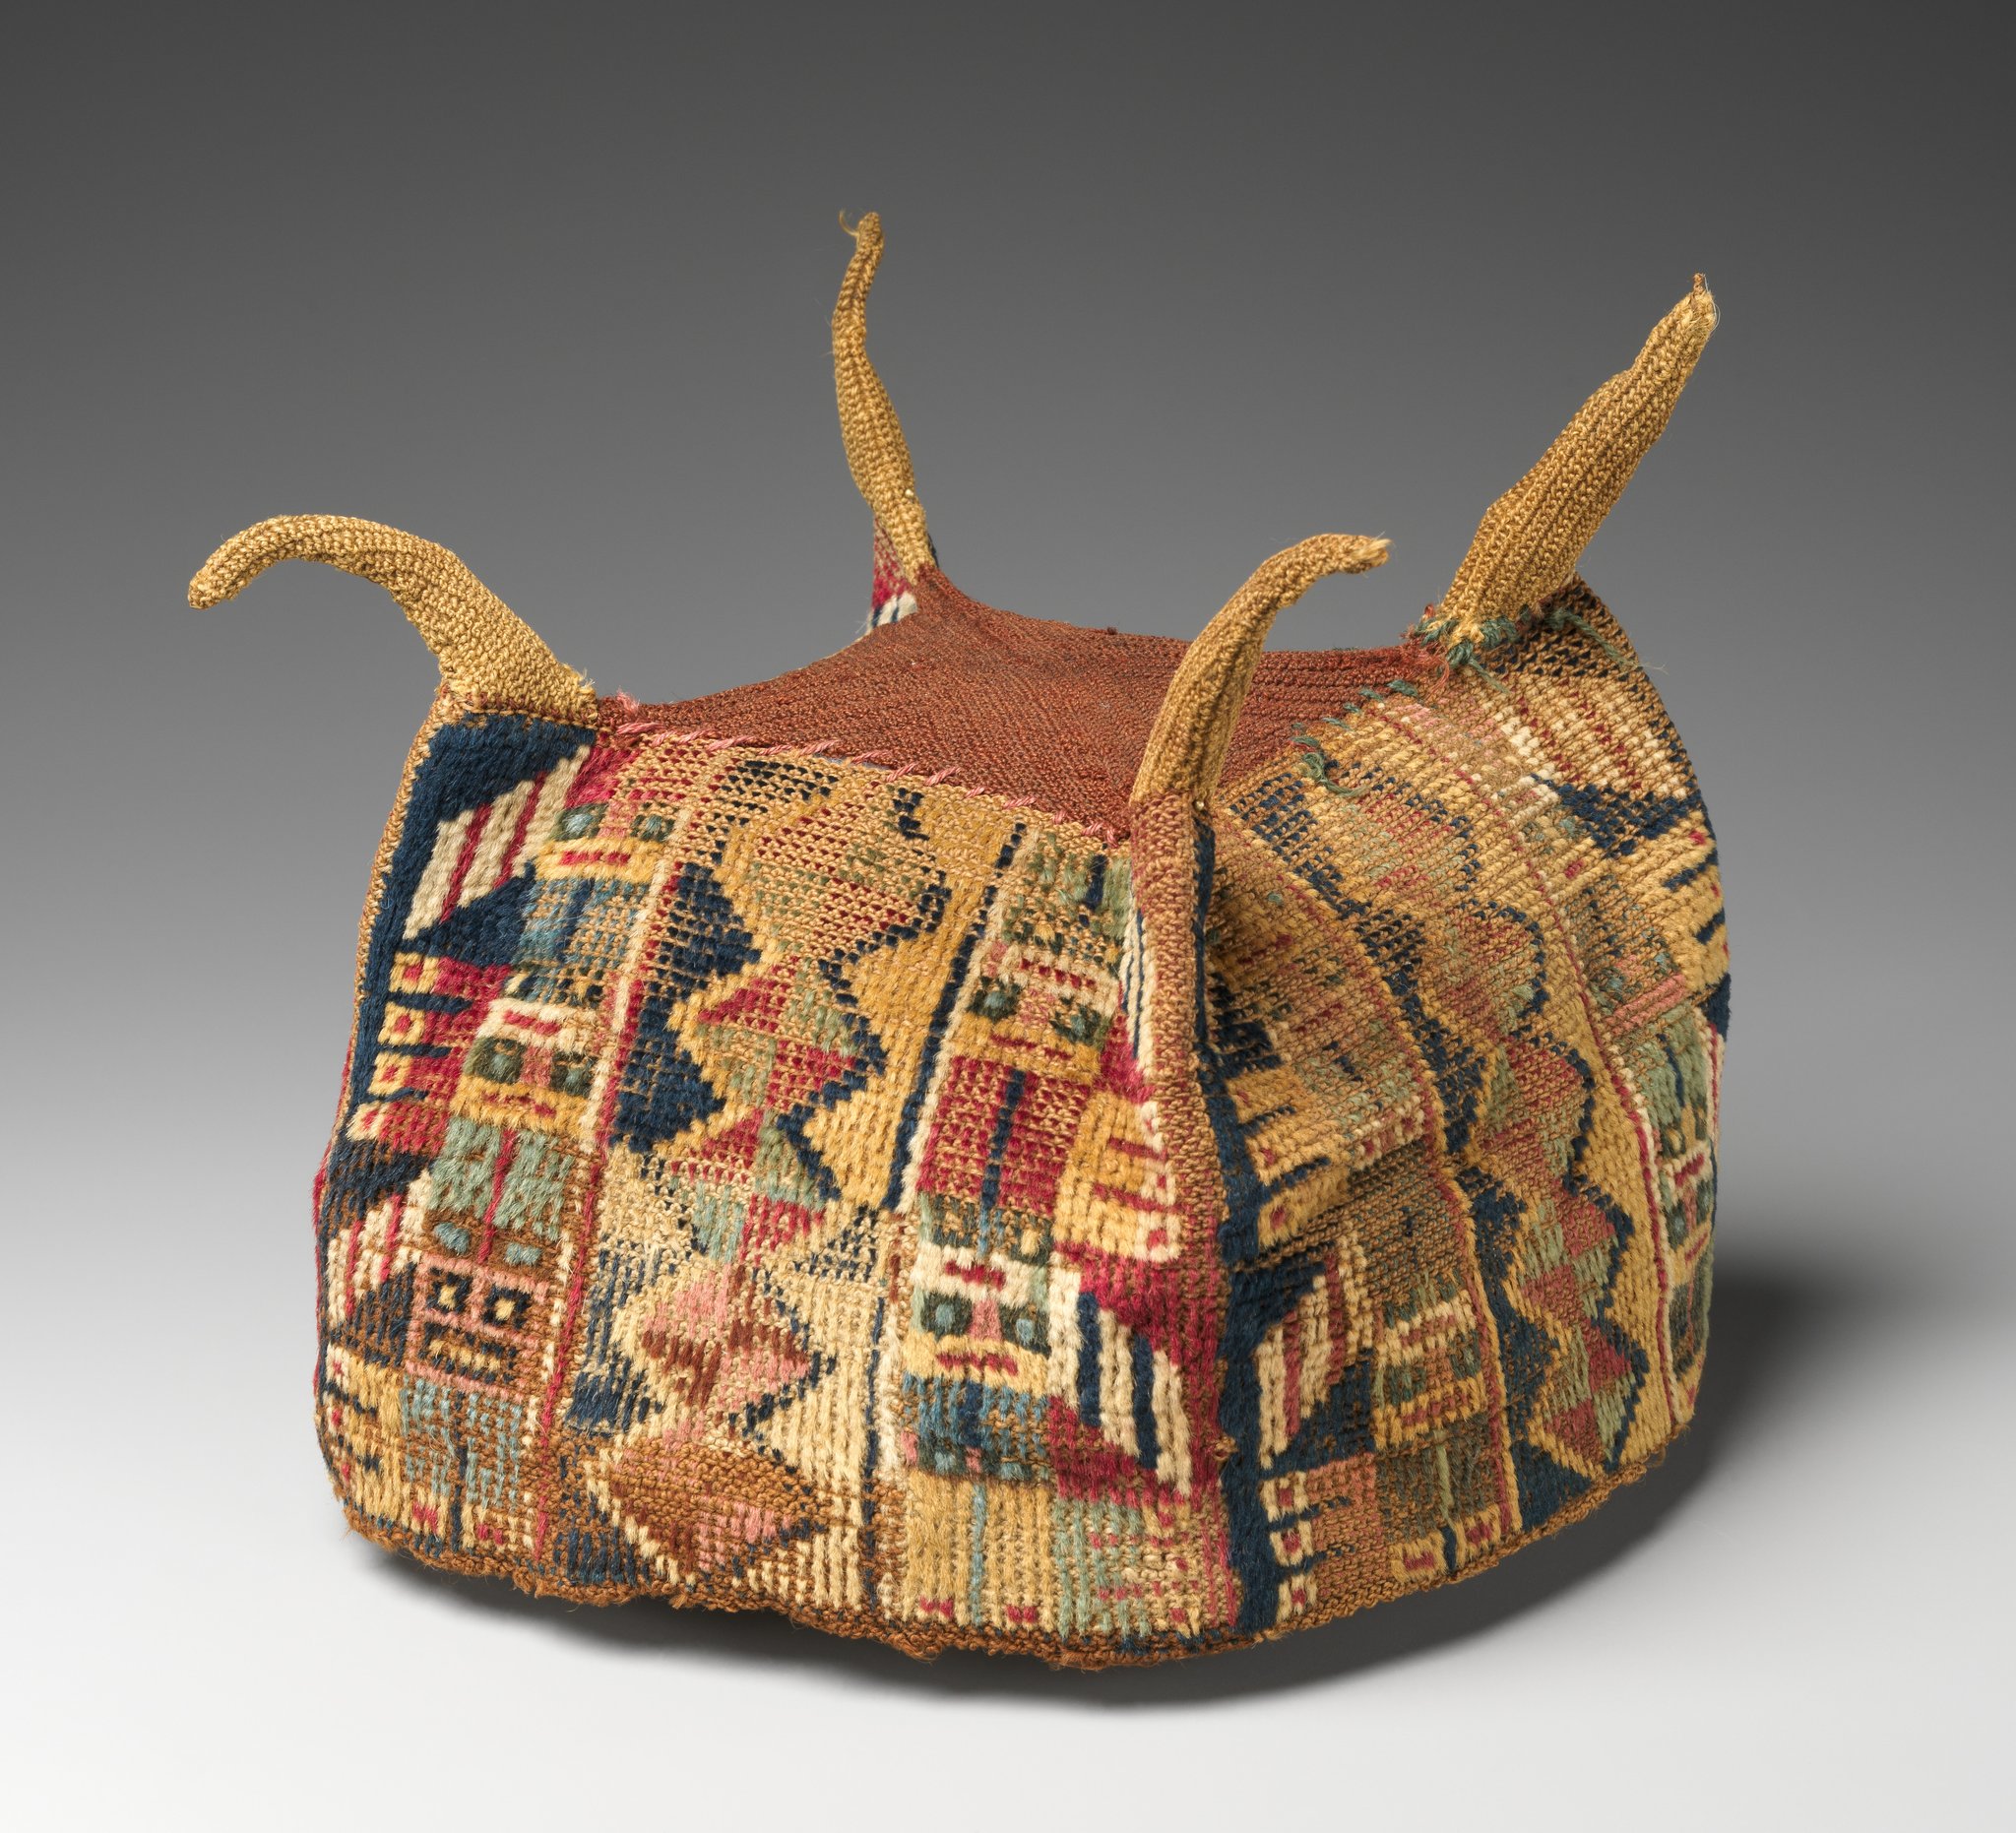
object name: hat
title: Four-Cornered Hat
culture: wari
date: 601-900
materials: animal fiber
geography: peru